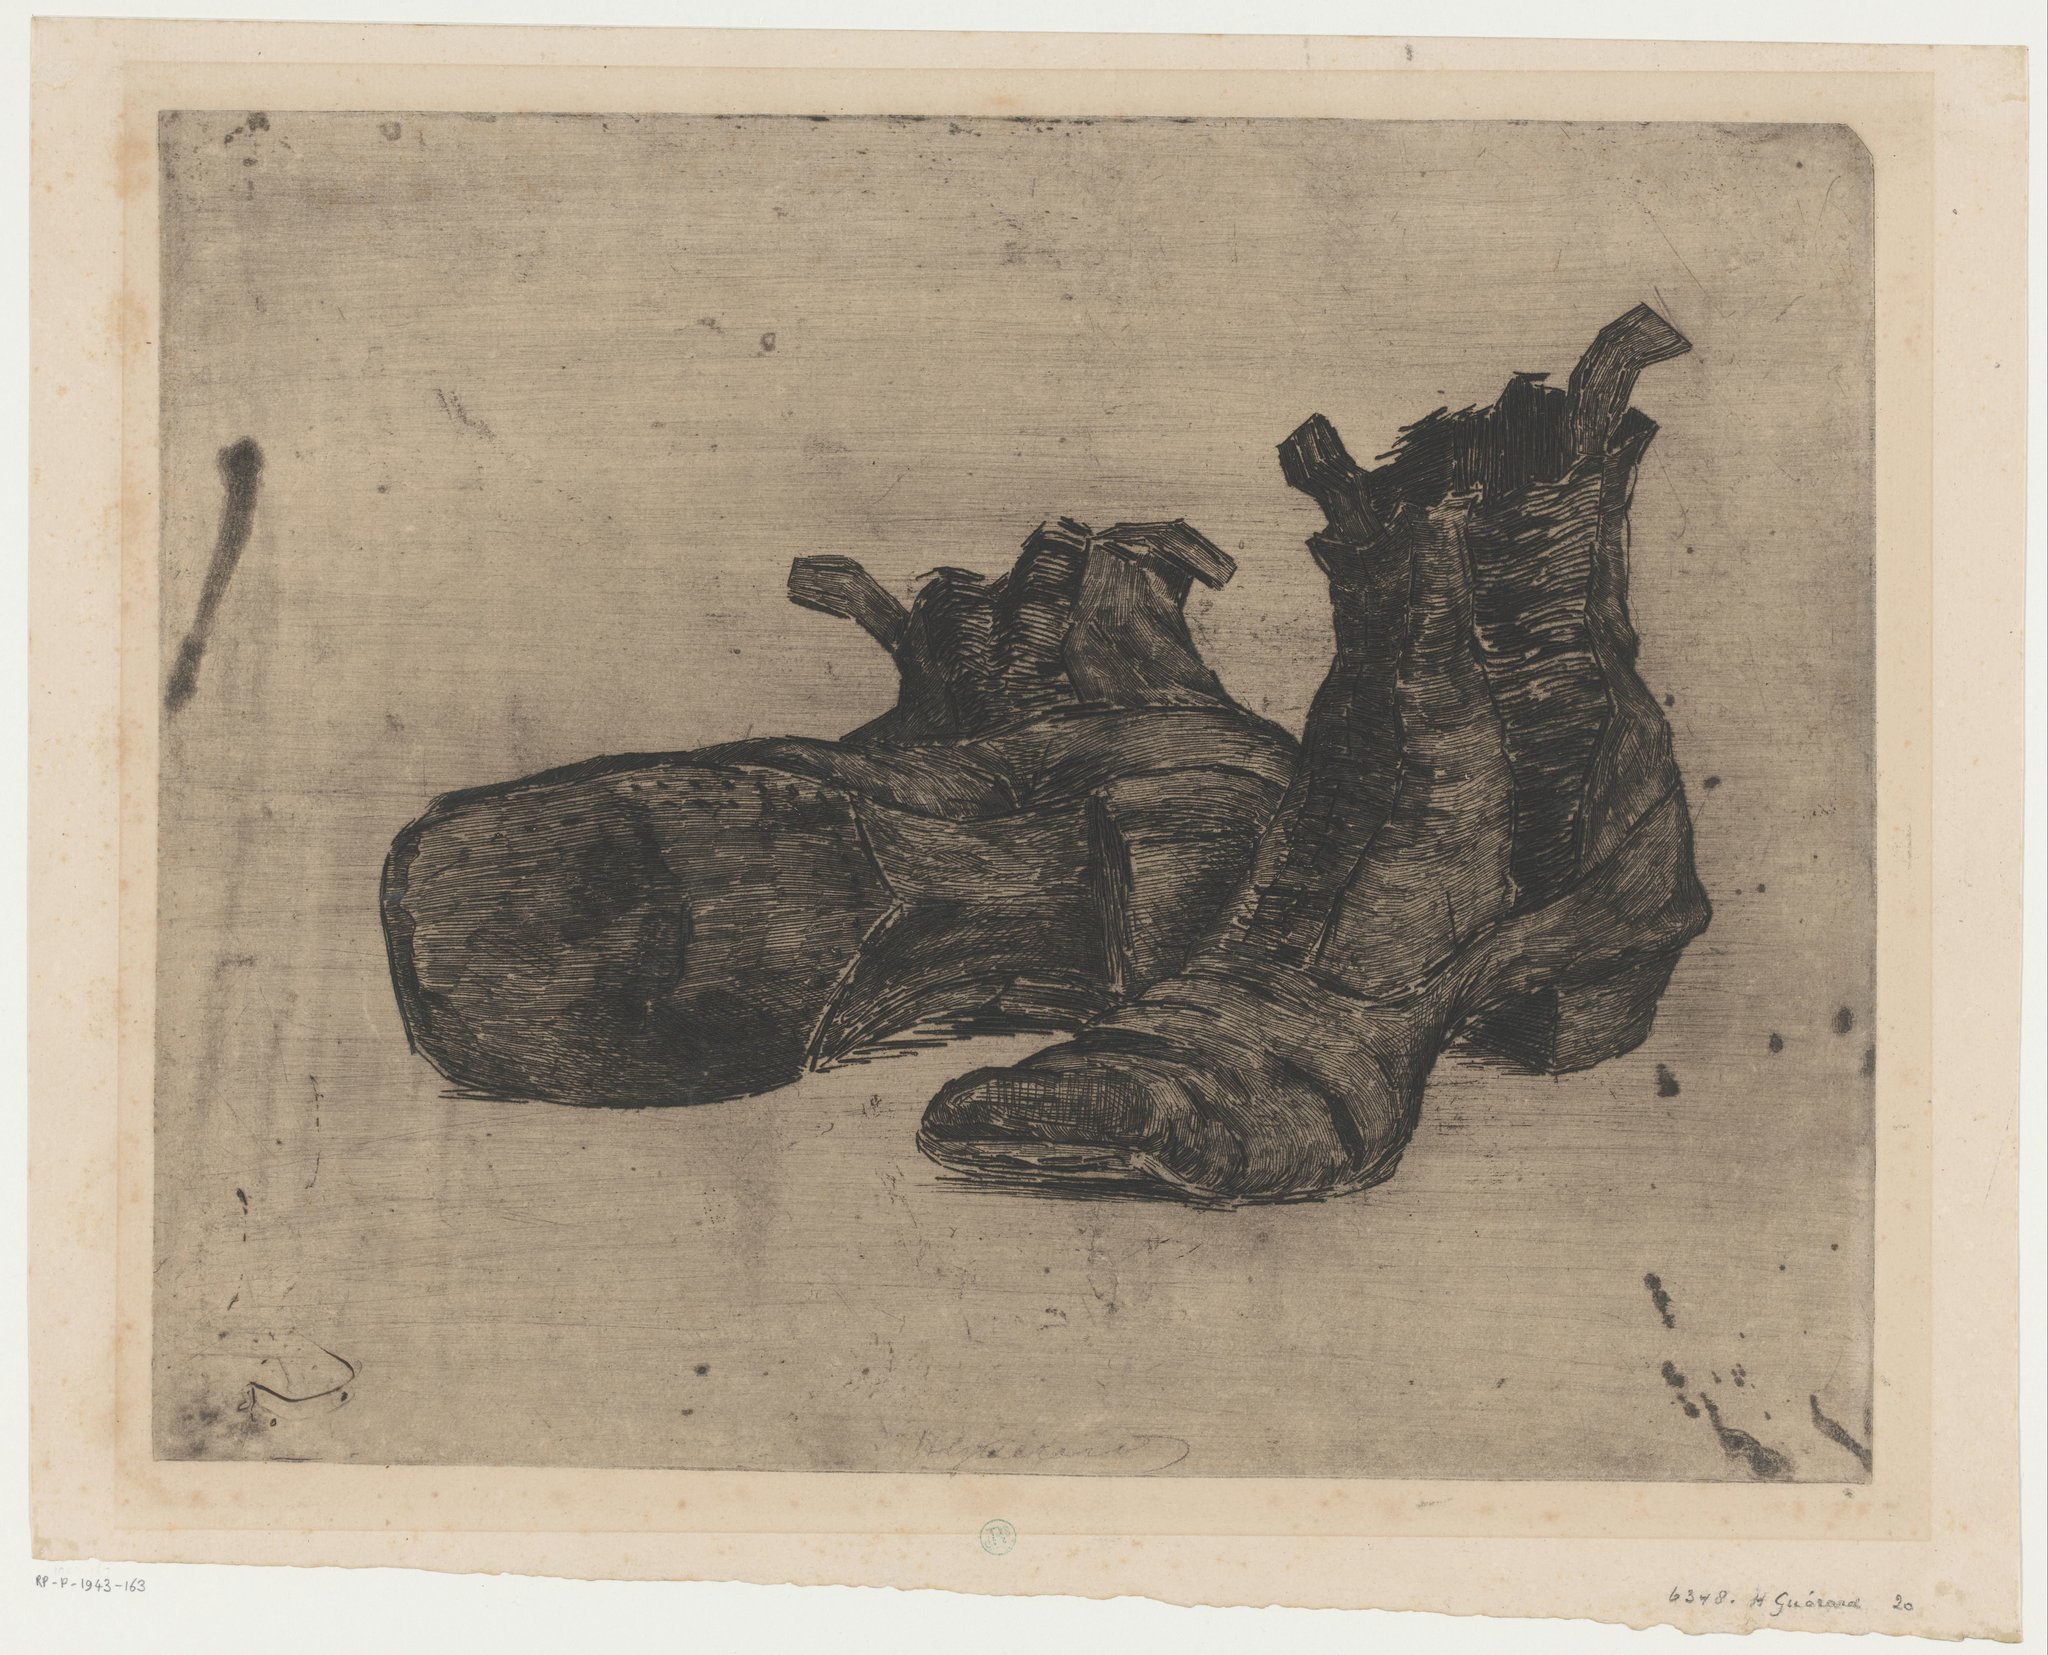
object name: print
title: Paar laarzen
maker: henri charles guérard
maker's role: print maker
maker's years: 1846-1897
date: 1856-1897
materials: paper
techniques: etching, intaglio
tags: boots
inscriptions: collector's mark: Lugt 733, collector's mark: Lugt 2228